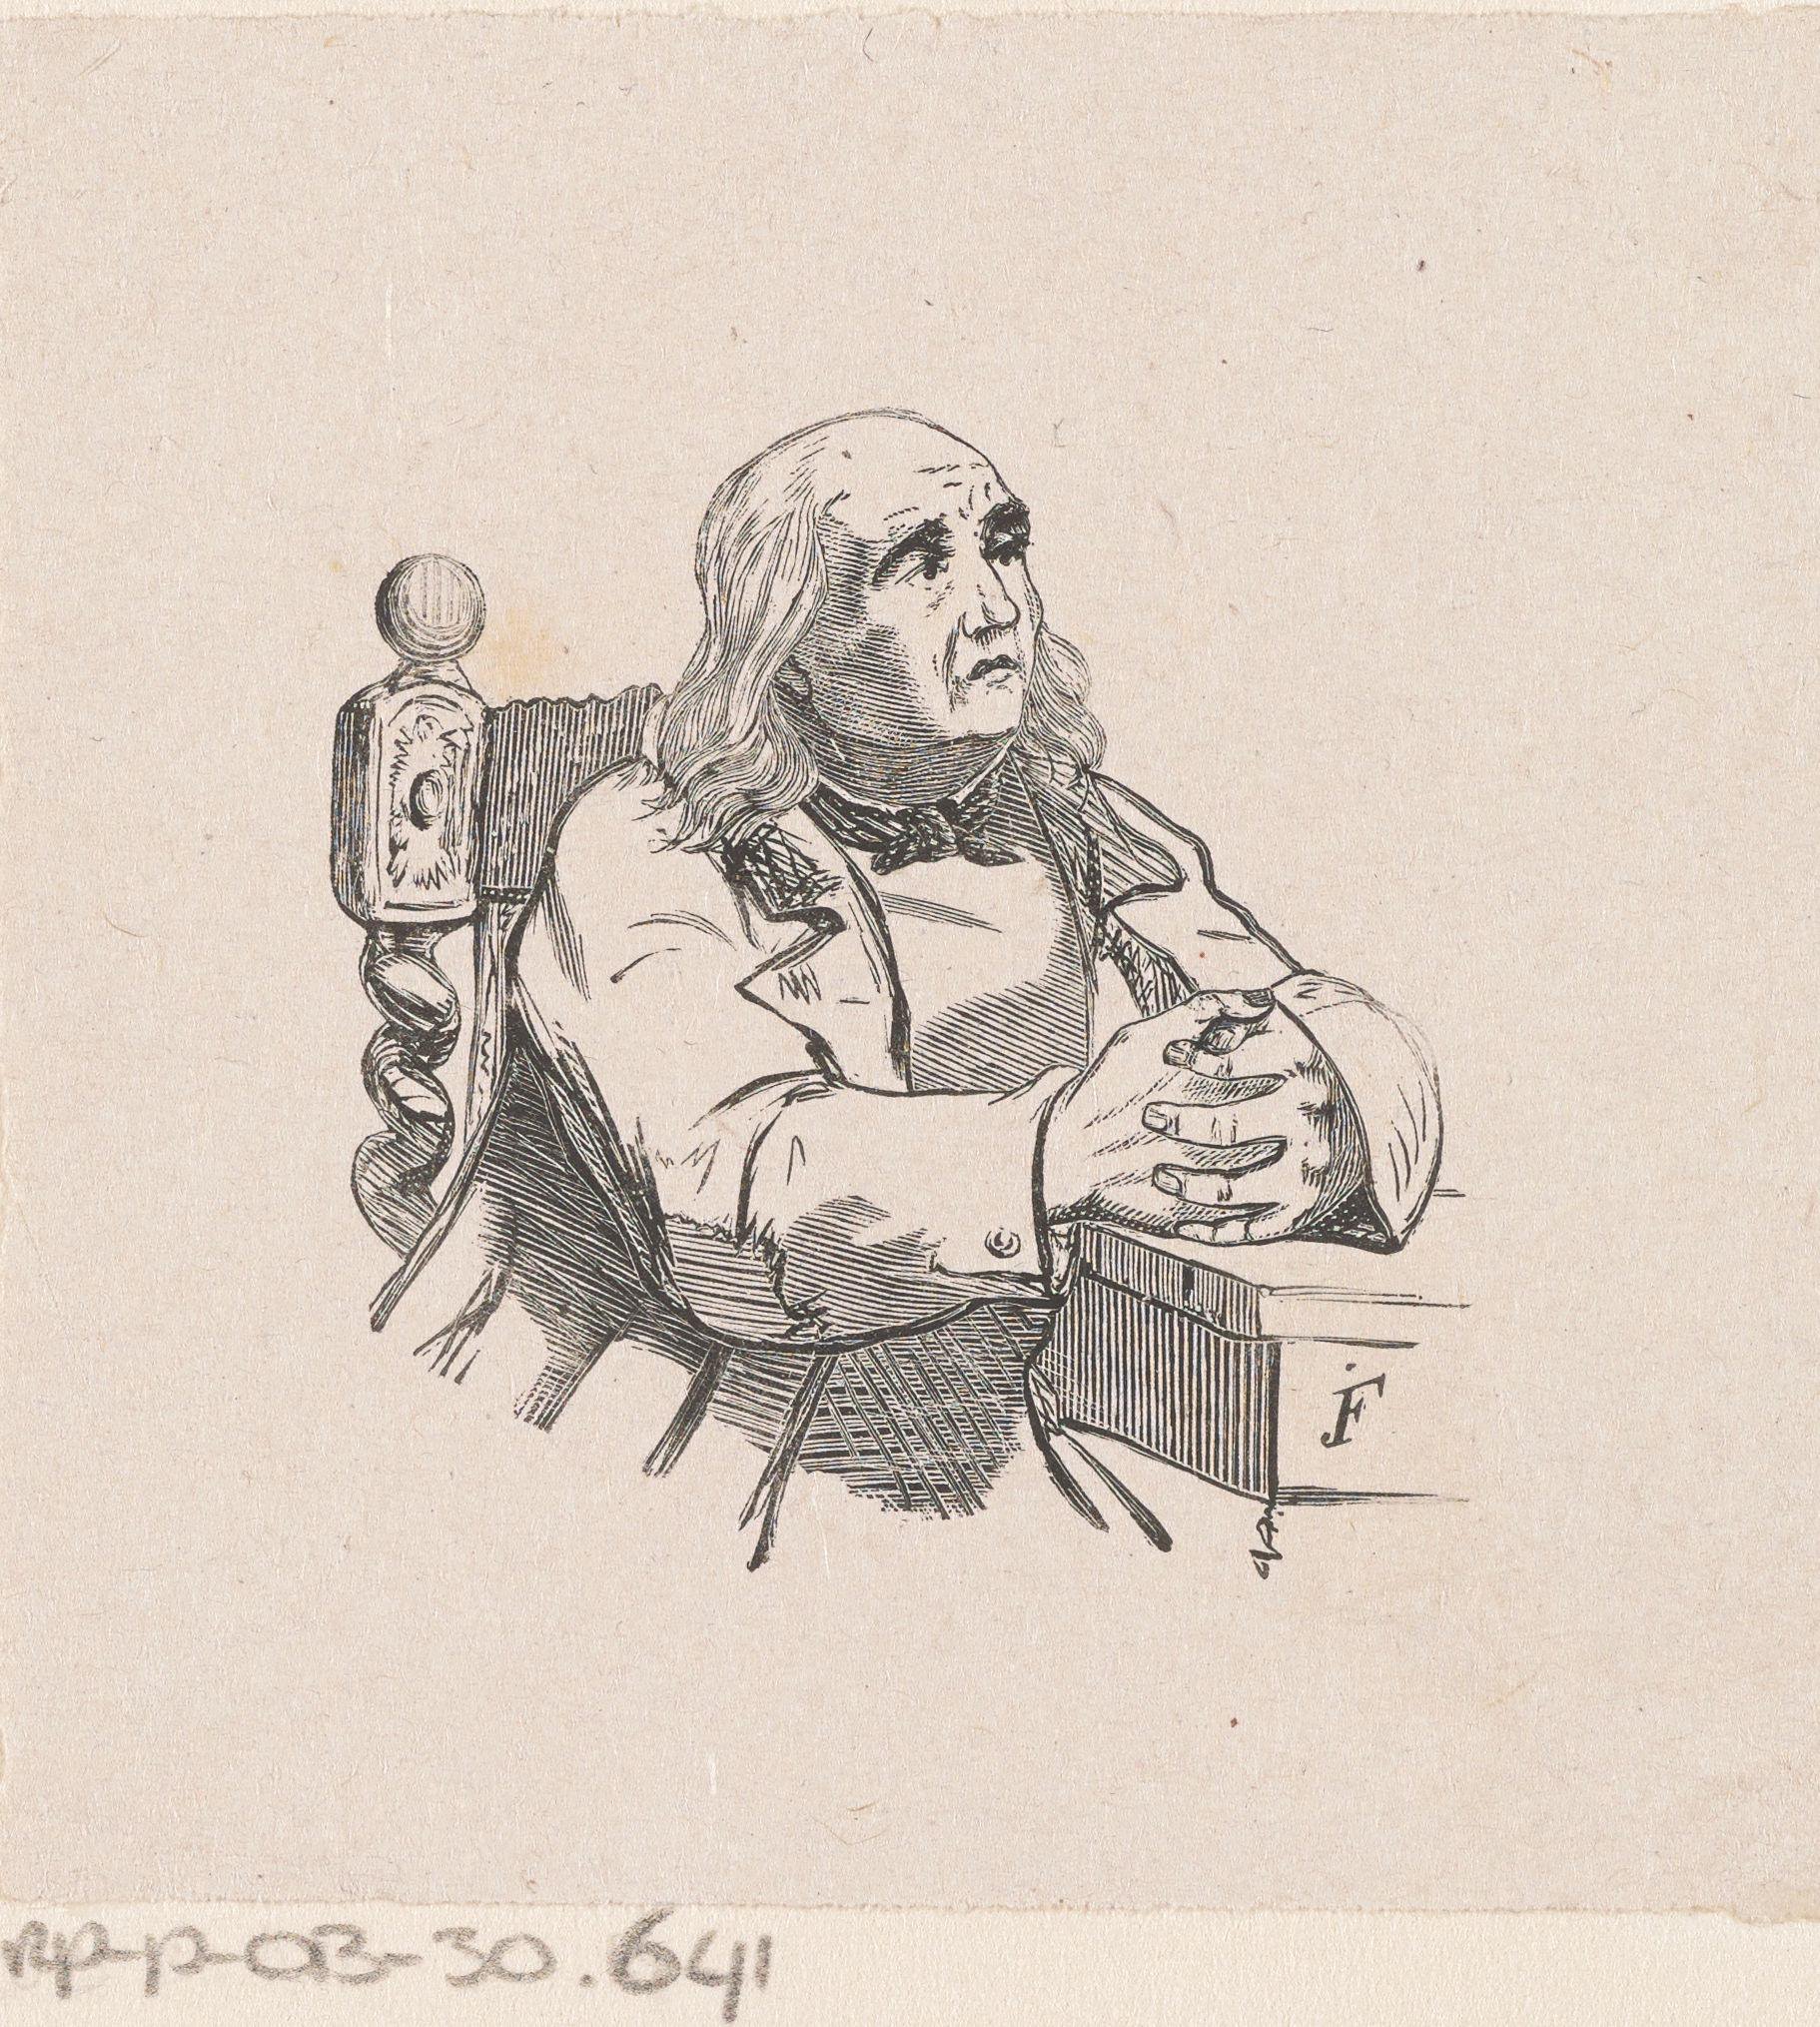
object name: print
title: Oude man in gebed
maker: isaac weissenbruch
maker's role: print maker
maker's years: 1826-1912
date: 1836-1912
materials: paper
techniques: engraving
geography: netherlands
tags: old man, one person praying